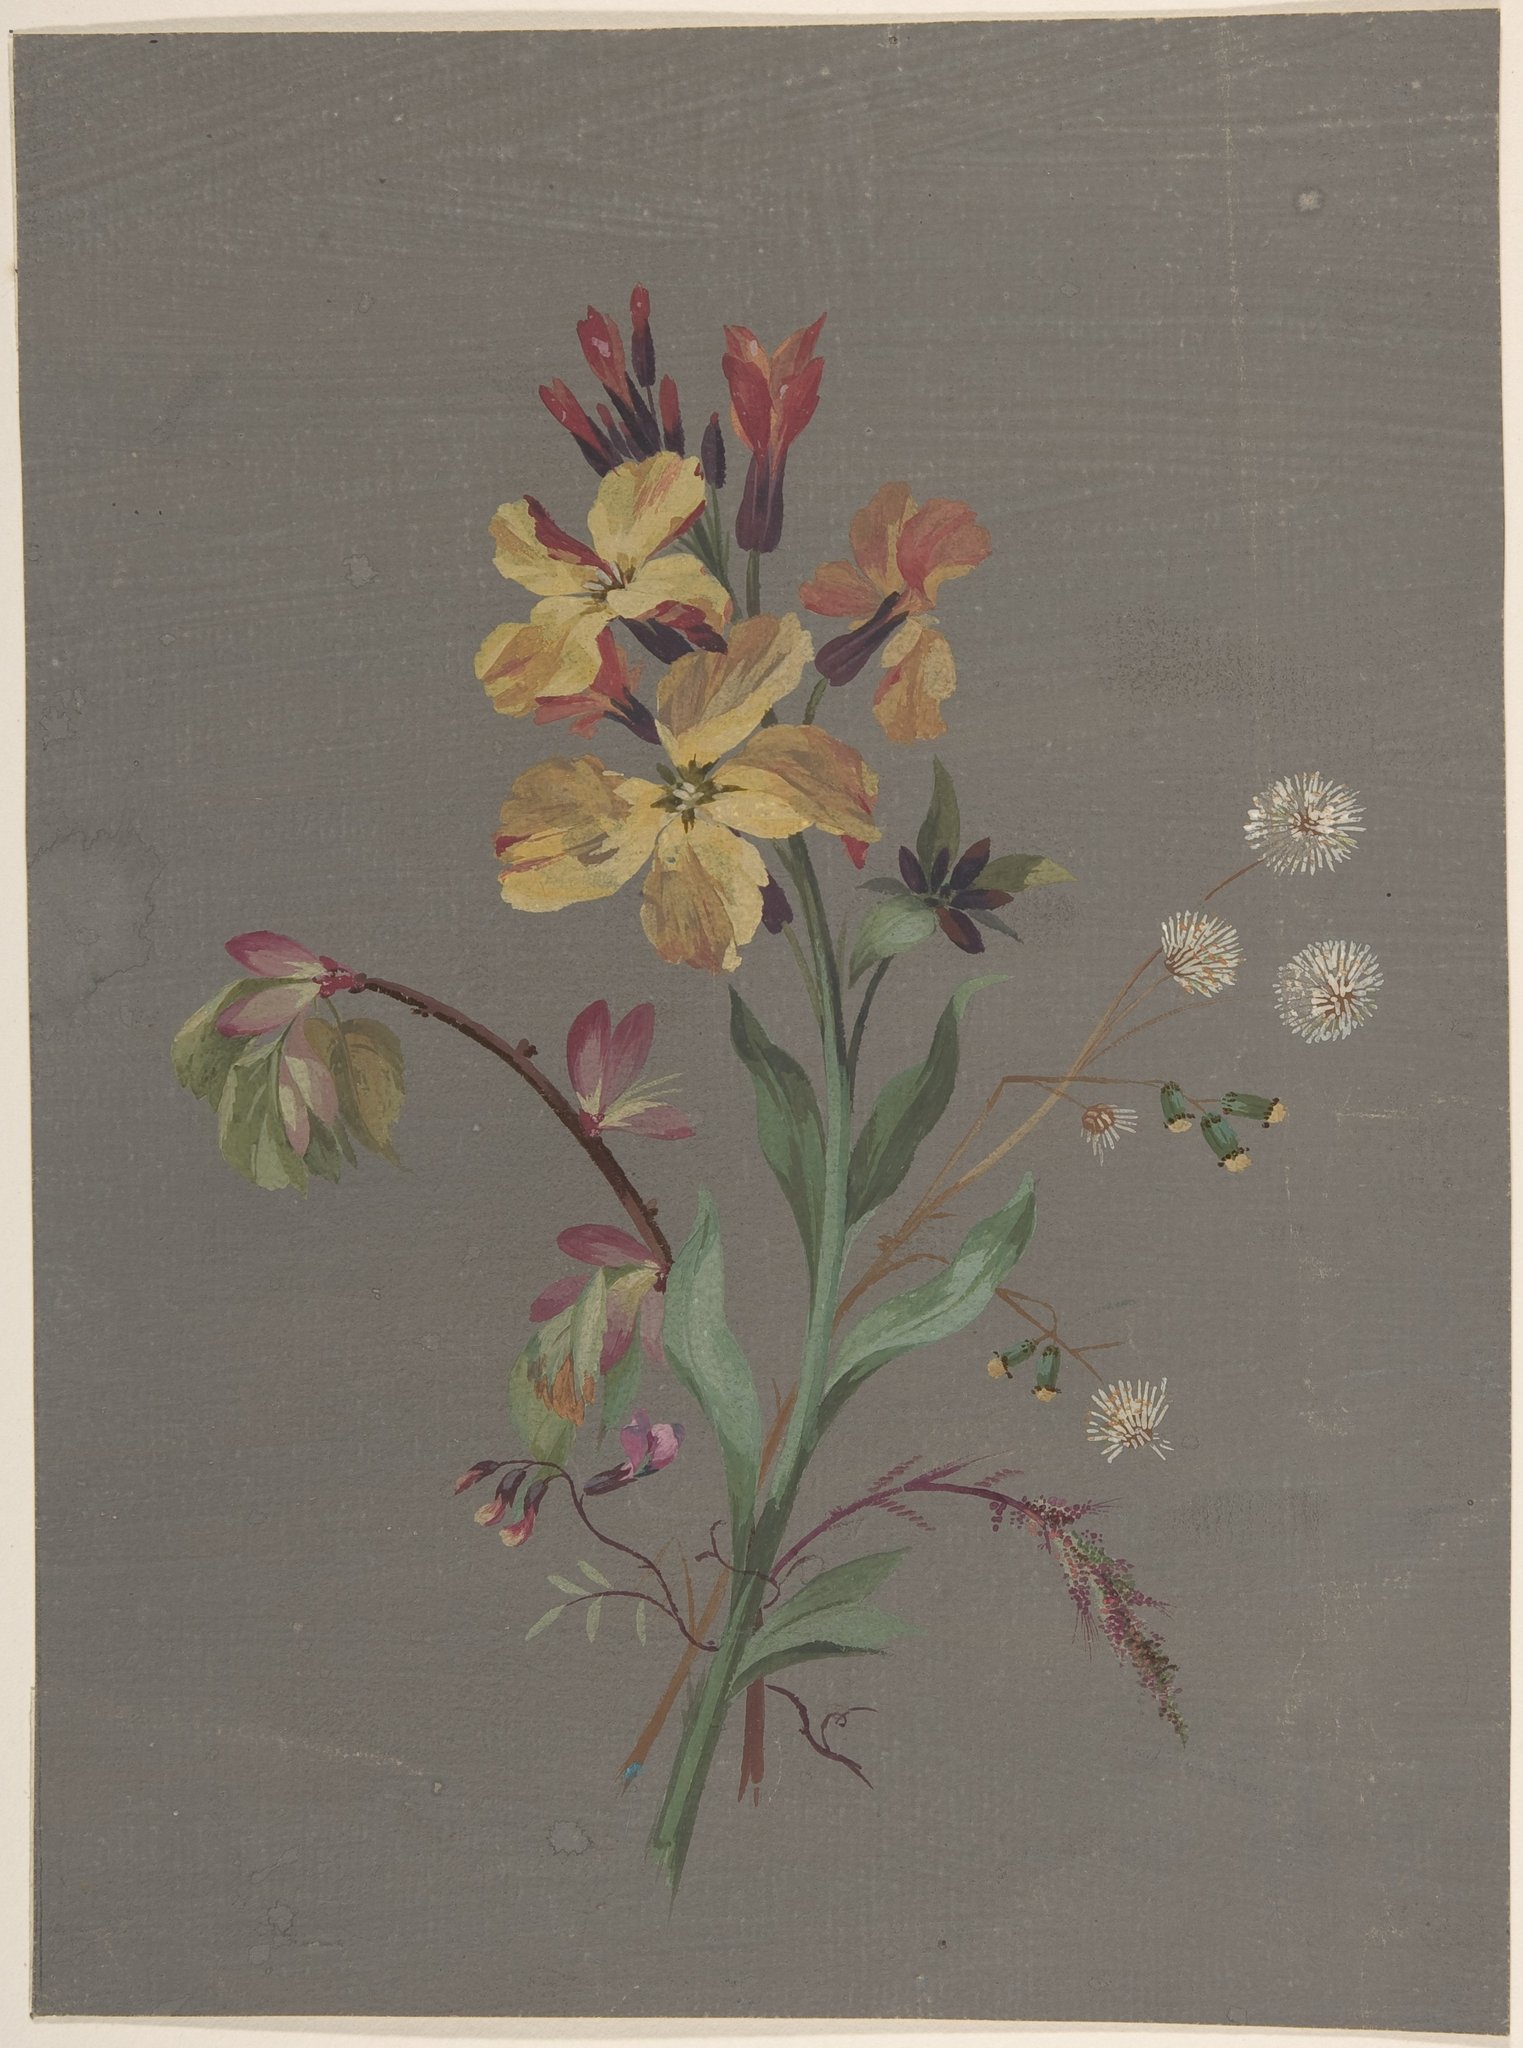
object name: drawing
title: Floral Design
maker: antoine berjon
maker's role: artist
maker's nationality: french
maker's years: 1754-1843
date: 1820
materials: gouache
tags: flowers